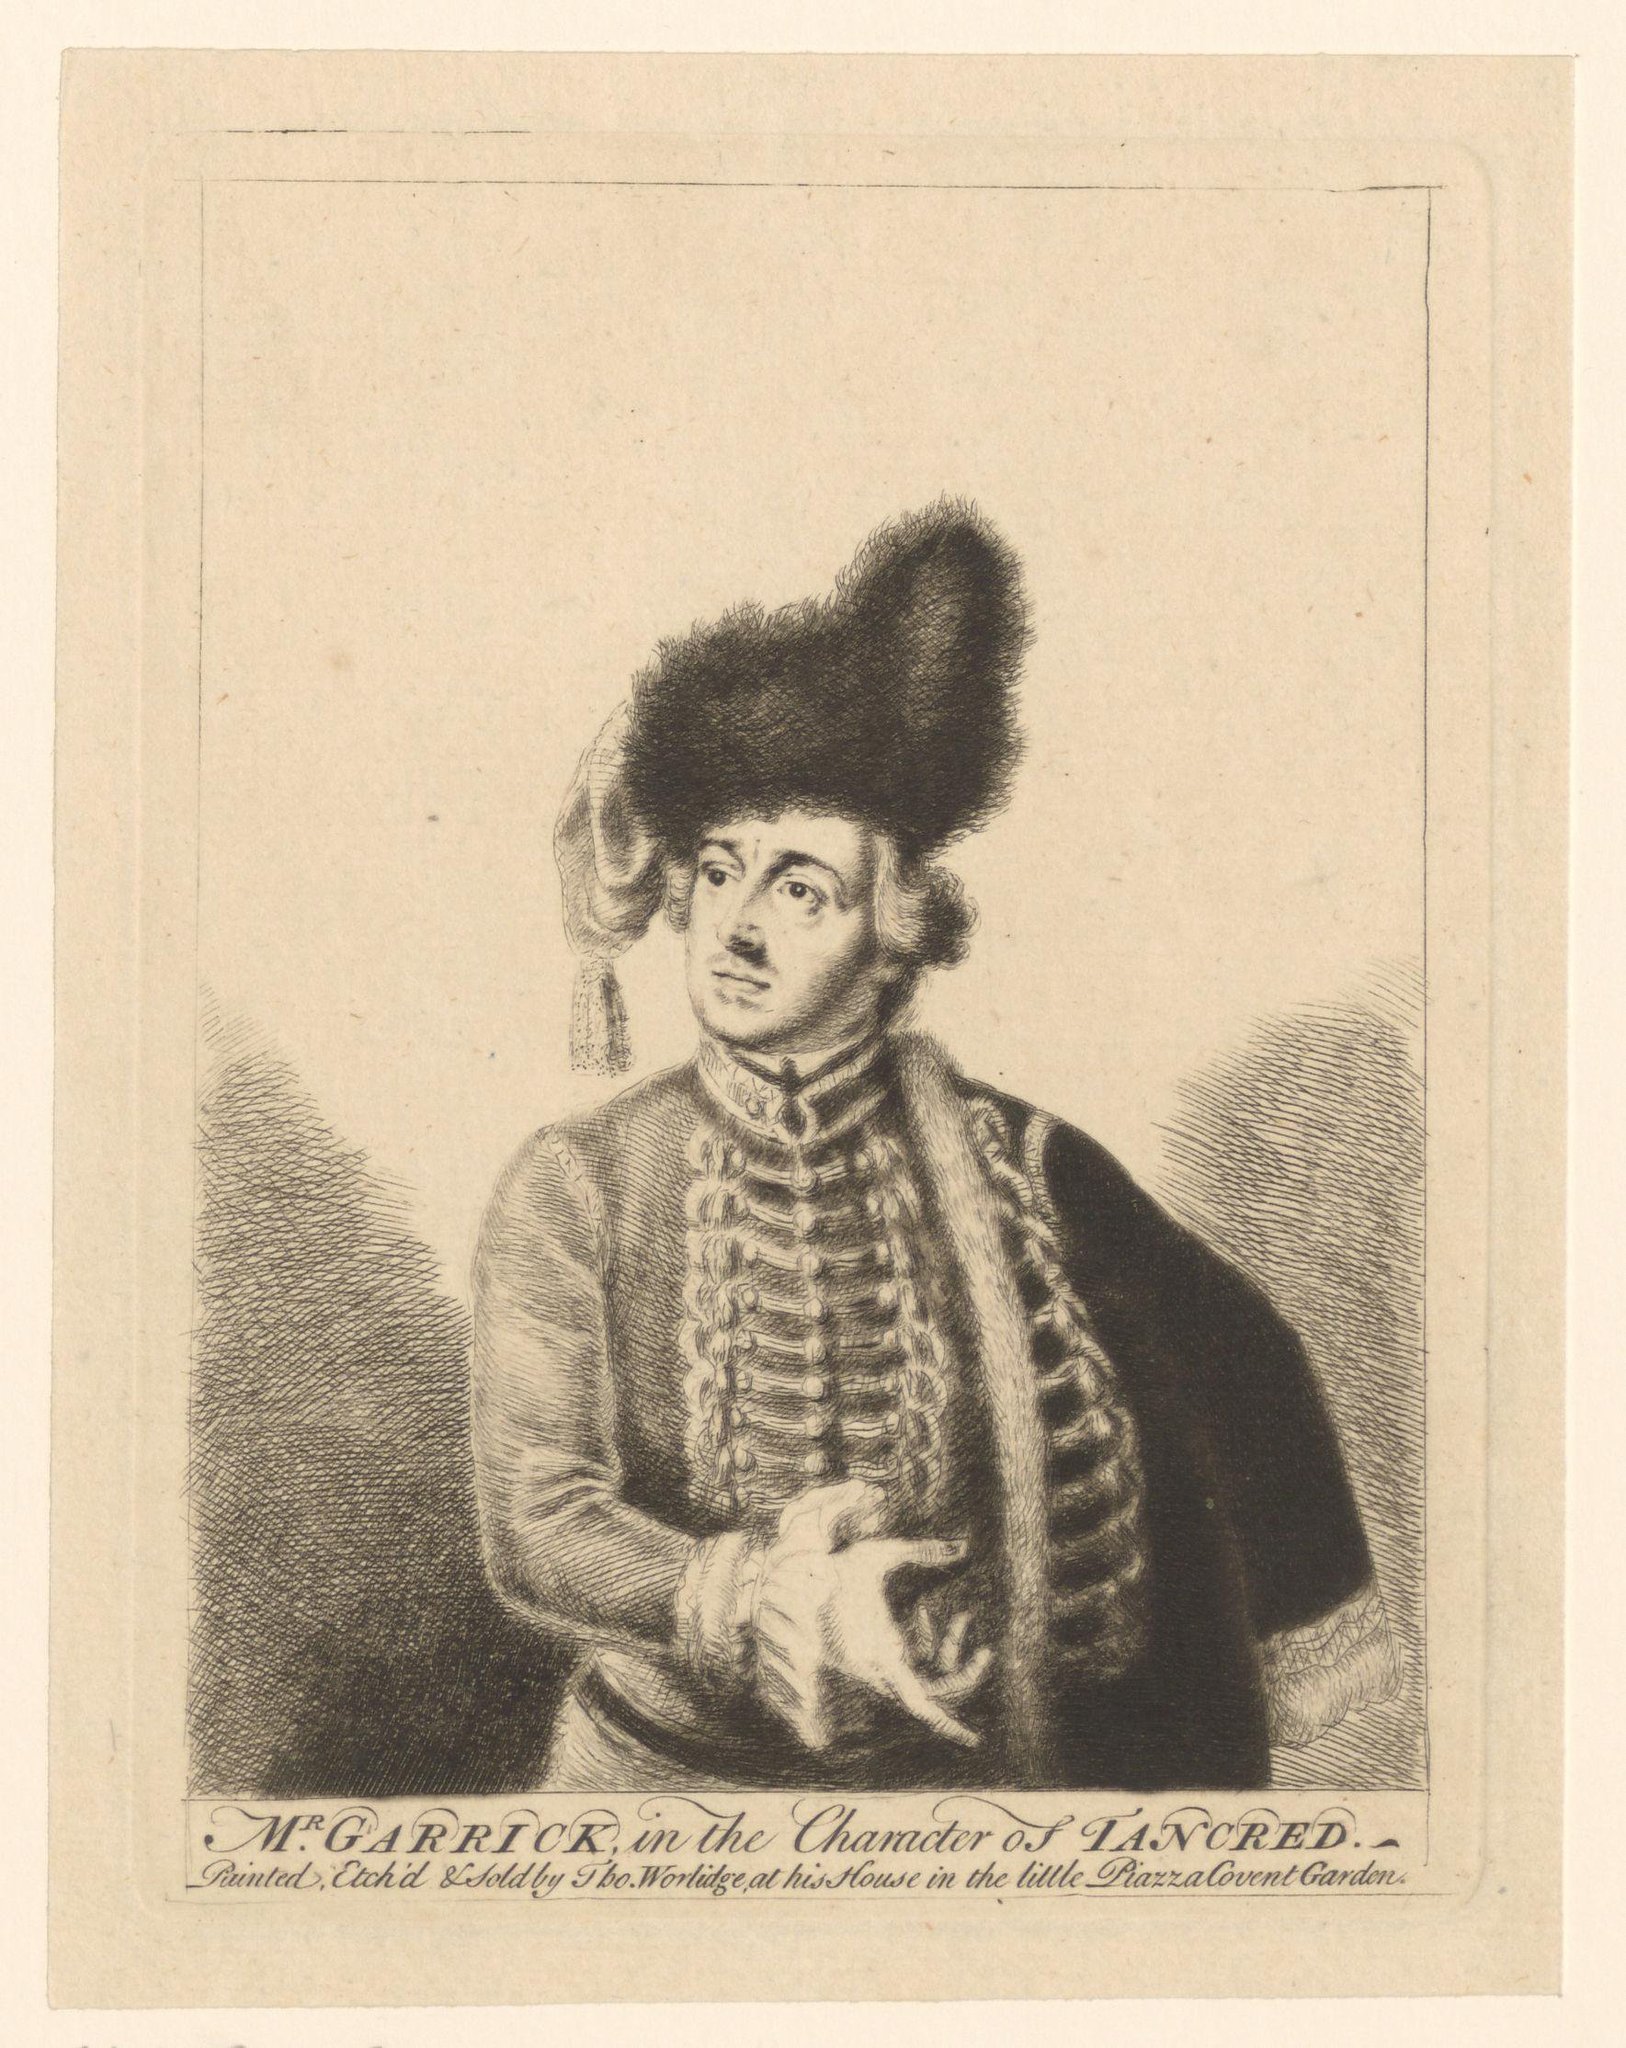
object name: print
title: Mr. Garrick in the Character of Tancred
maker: thomas worlidge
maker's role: print maker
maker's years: 1700-1766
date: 1754-1766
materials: paper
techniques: drypoint, etching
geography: london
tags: london, david garrick, james thomson (1700-1748), names of literary characters, historical person (...) - historical person (...) portrayed alone, portrait of actor, actress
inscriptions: collector's mark: Lugt 240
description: Portret van David Garrick als het personage 'Tancred', uit James Thomsons 'Tancred en Sigismunda'.